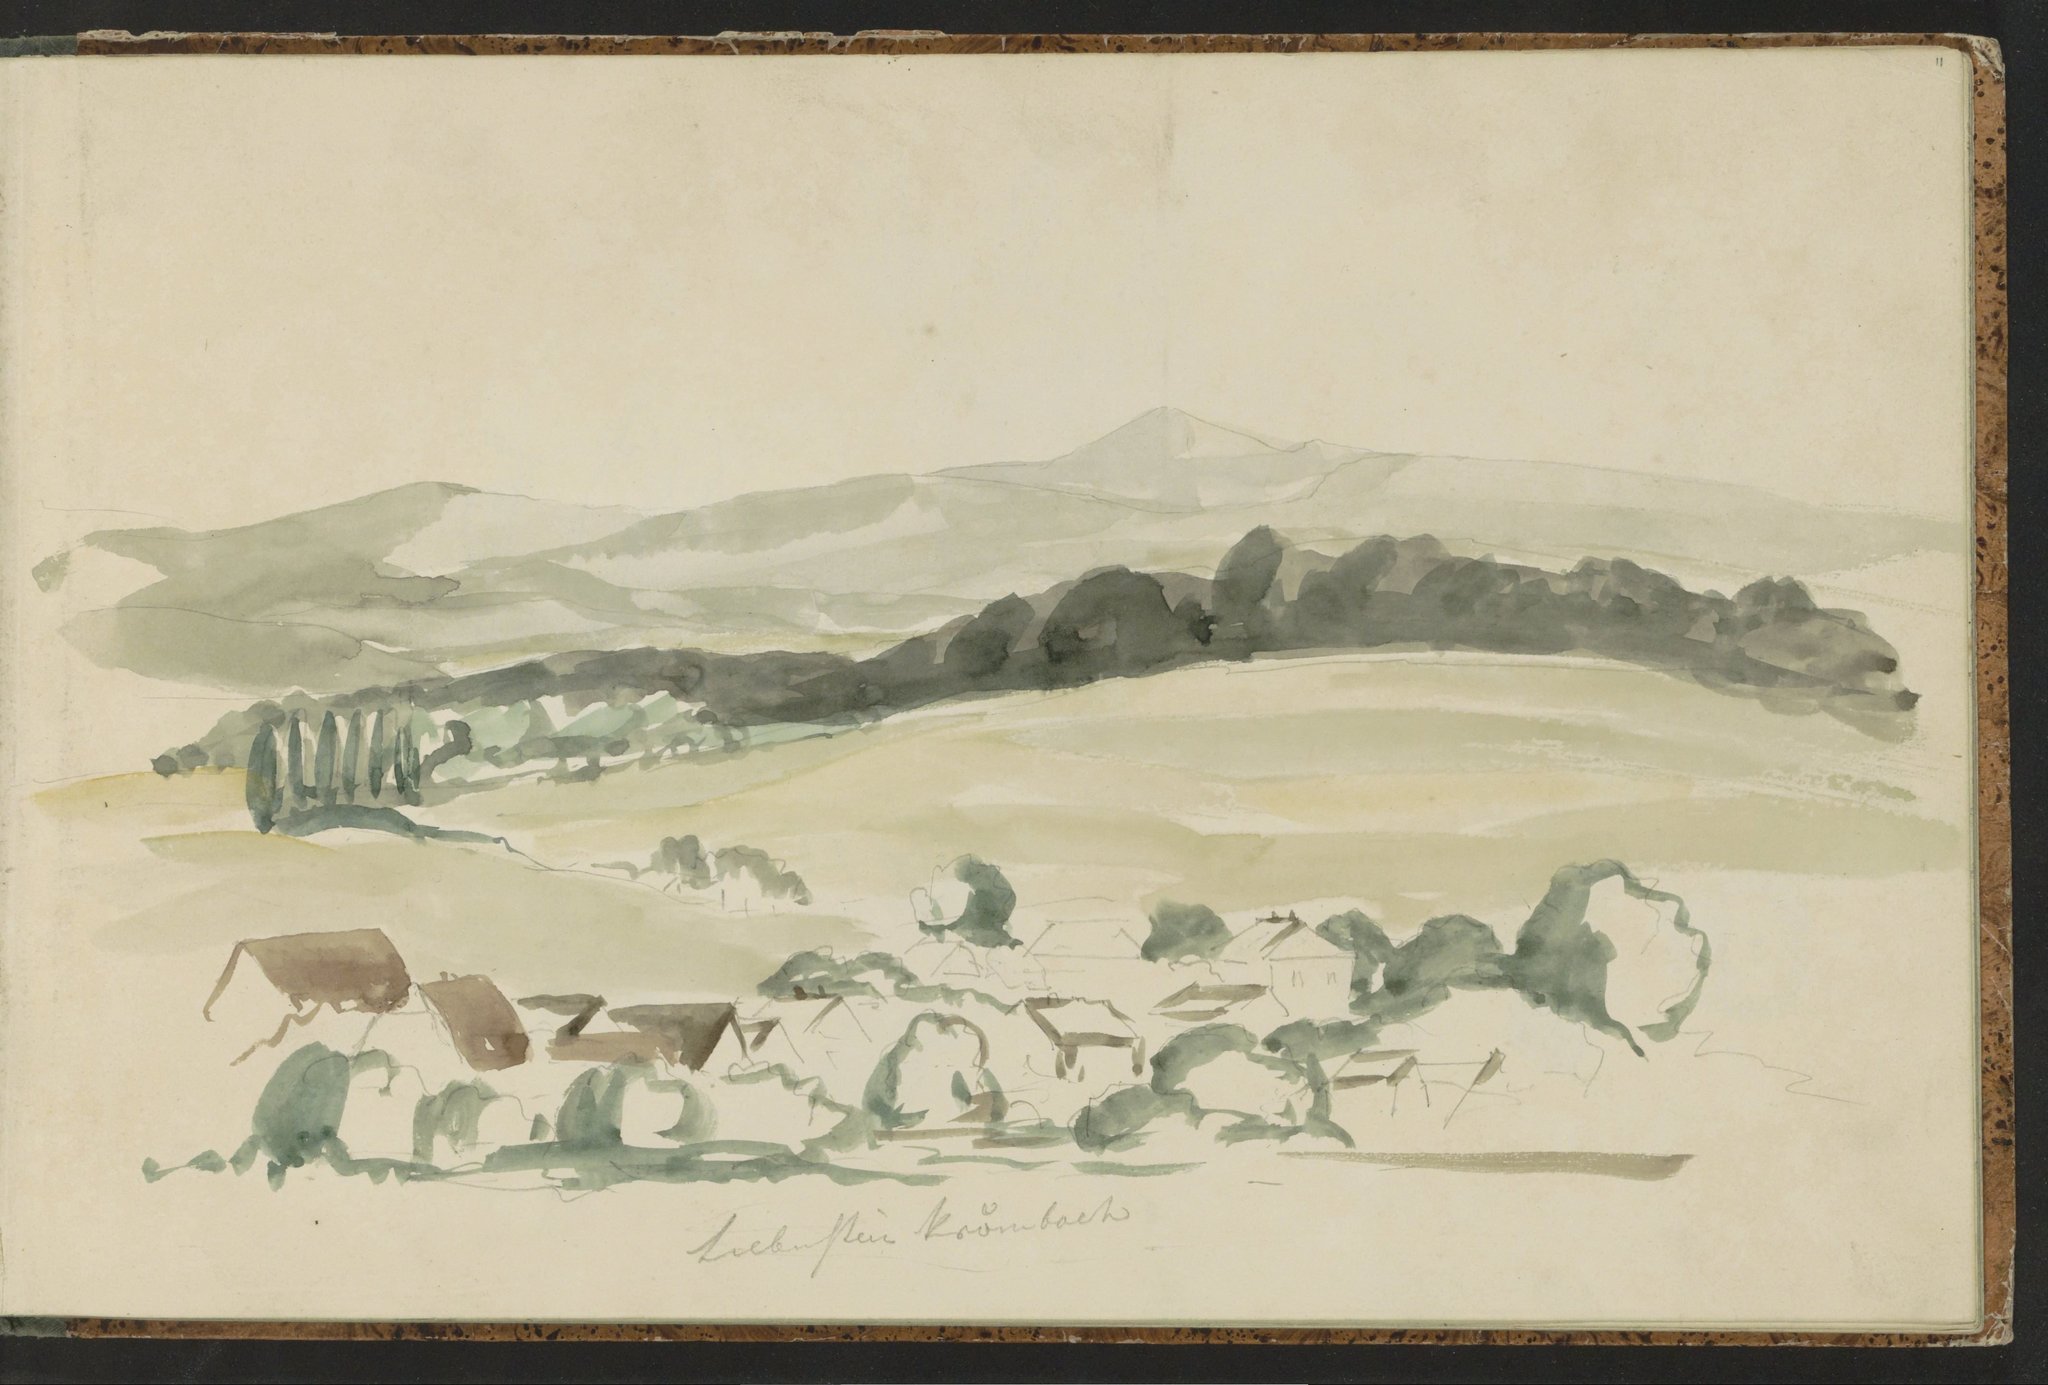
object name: sketchbook leaf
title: Dorp in een dal bij Liebenstein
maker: johannes tavenraat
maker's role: draughtsman, painter, print maker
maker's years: 1809-1881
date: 1840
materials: paper, pencil, watercolor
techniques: brush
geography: boppard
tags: dale, valley, village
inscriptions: annotation: ‘Liebenstein Krön[...]bach’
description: Blad 11 recto uit een schetsboek met 33 bladen.